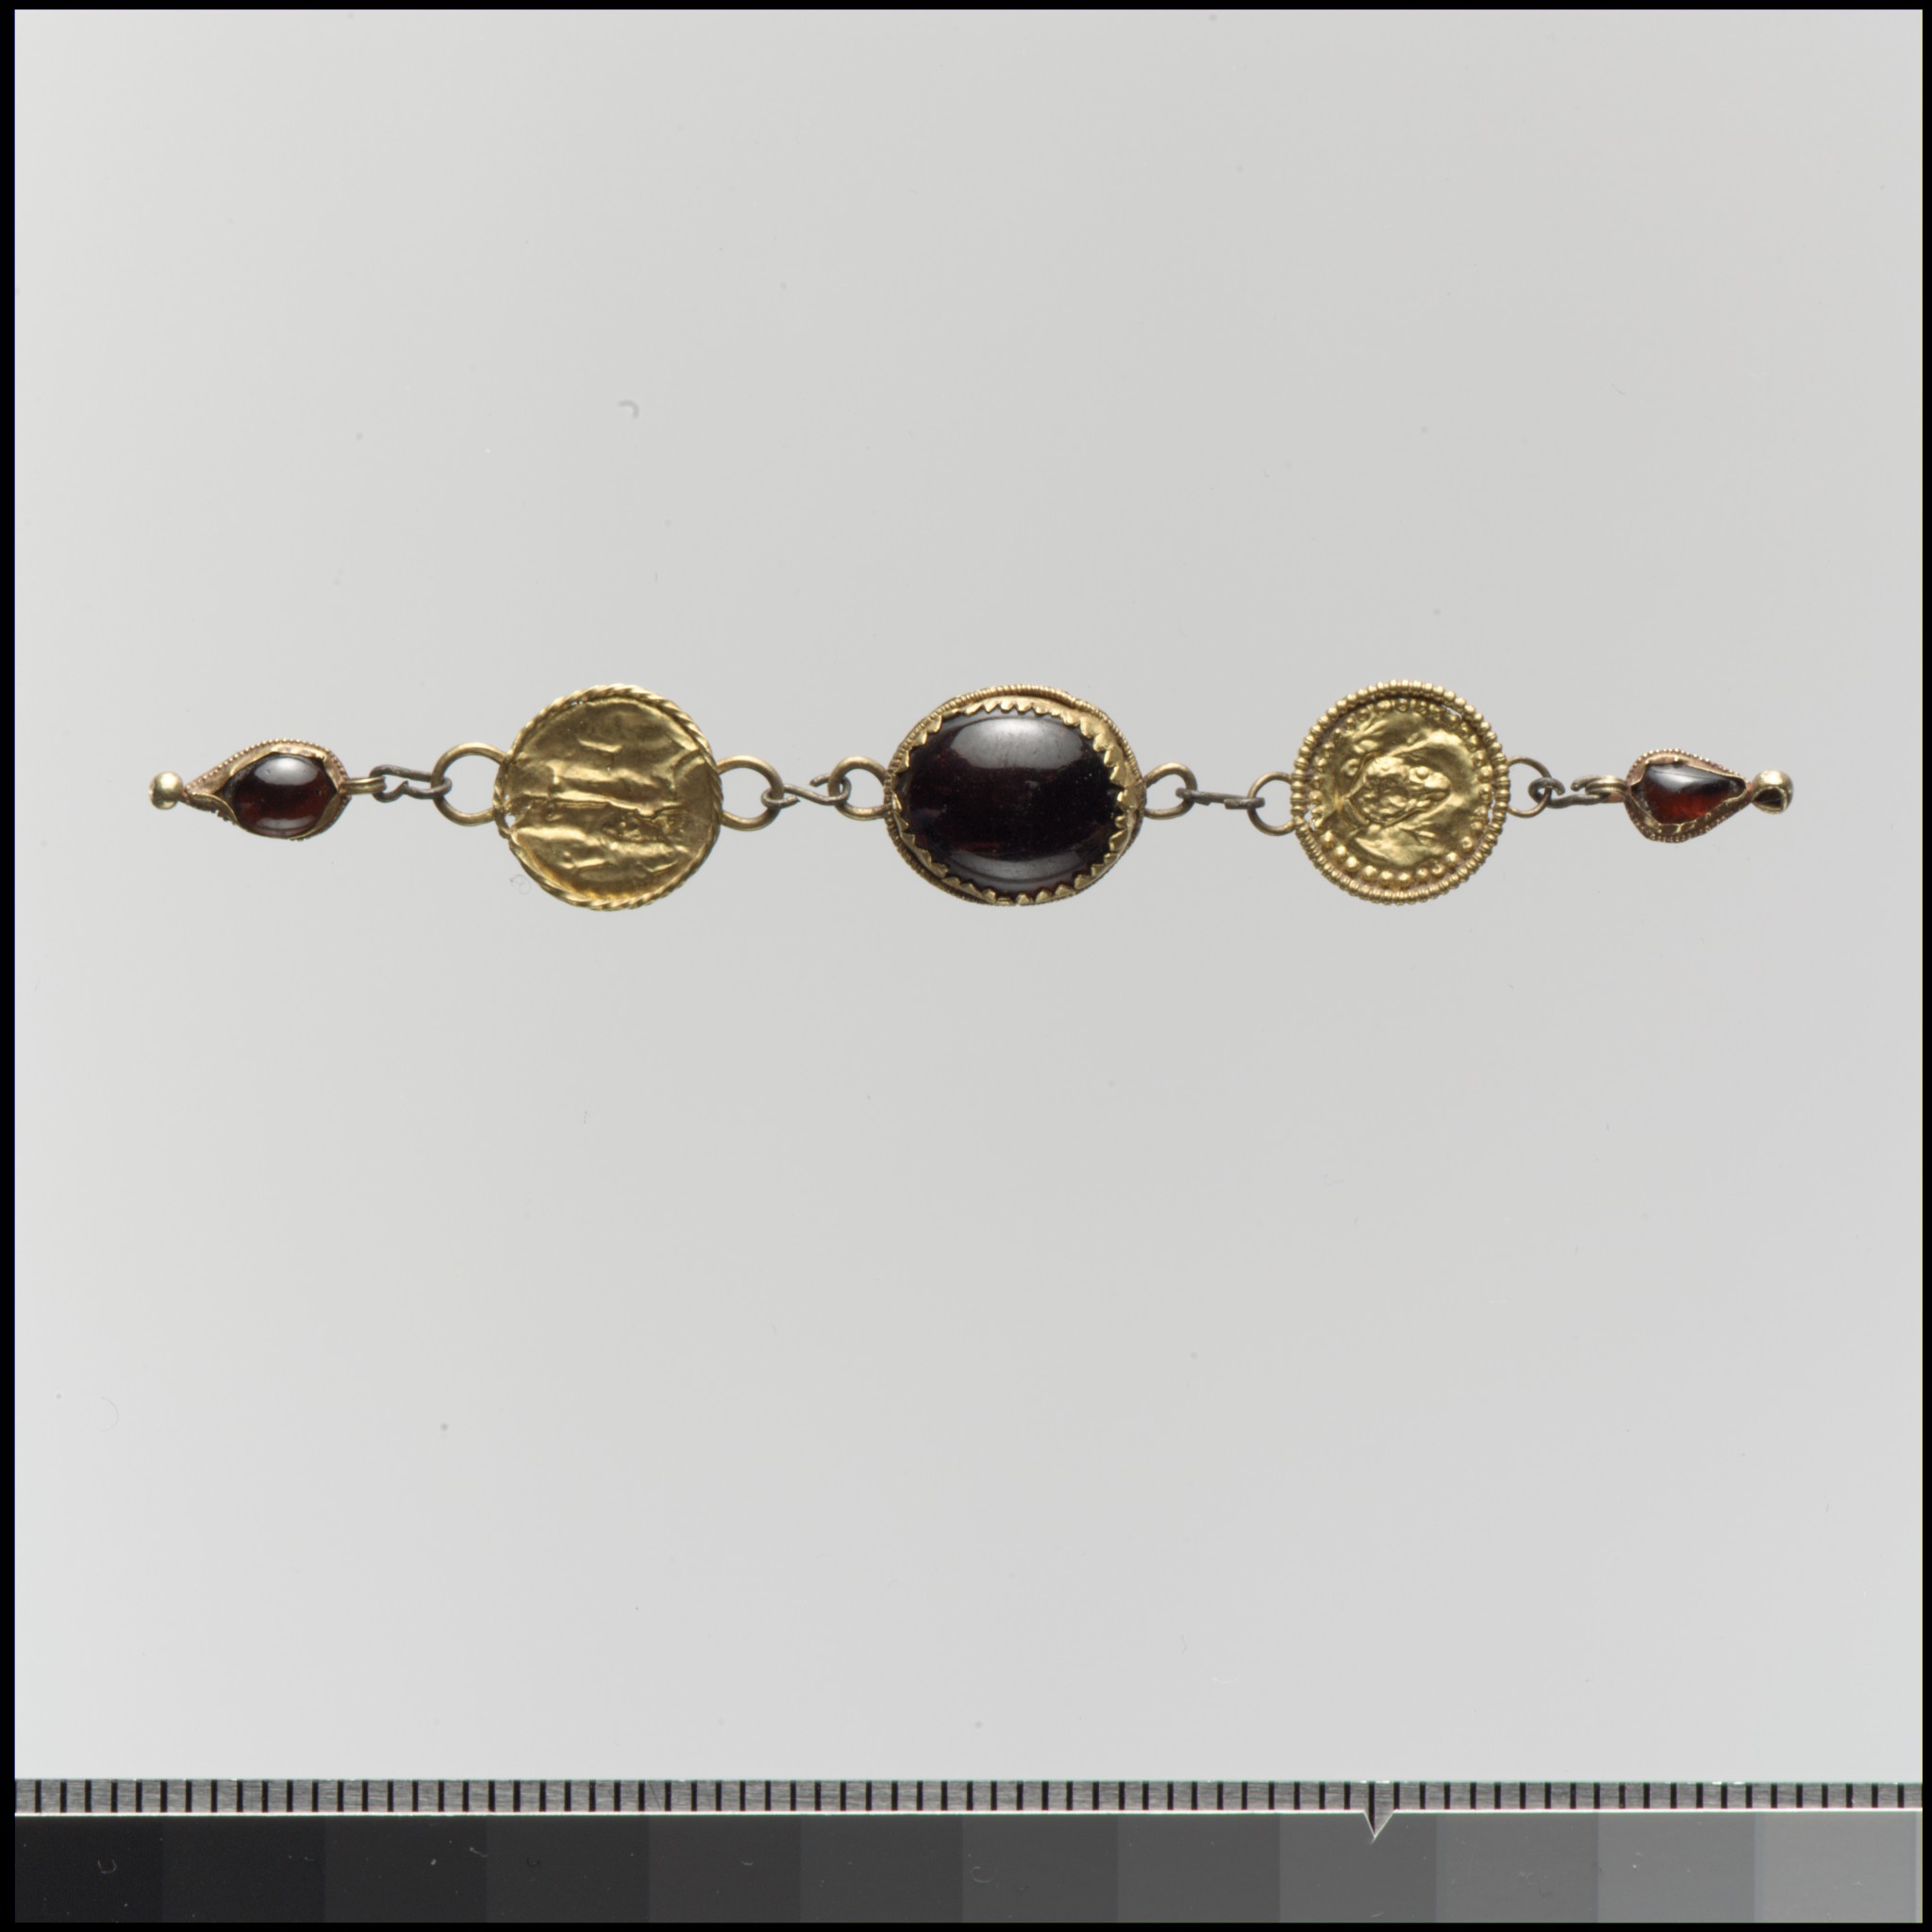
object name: necklace fragment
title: Fragment of Necklace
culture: pontic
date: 201-300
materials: garnet, gold